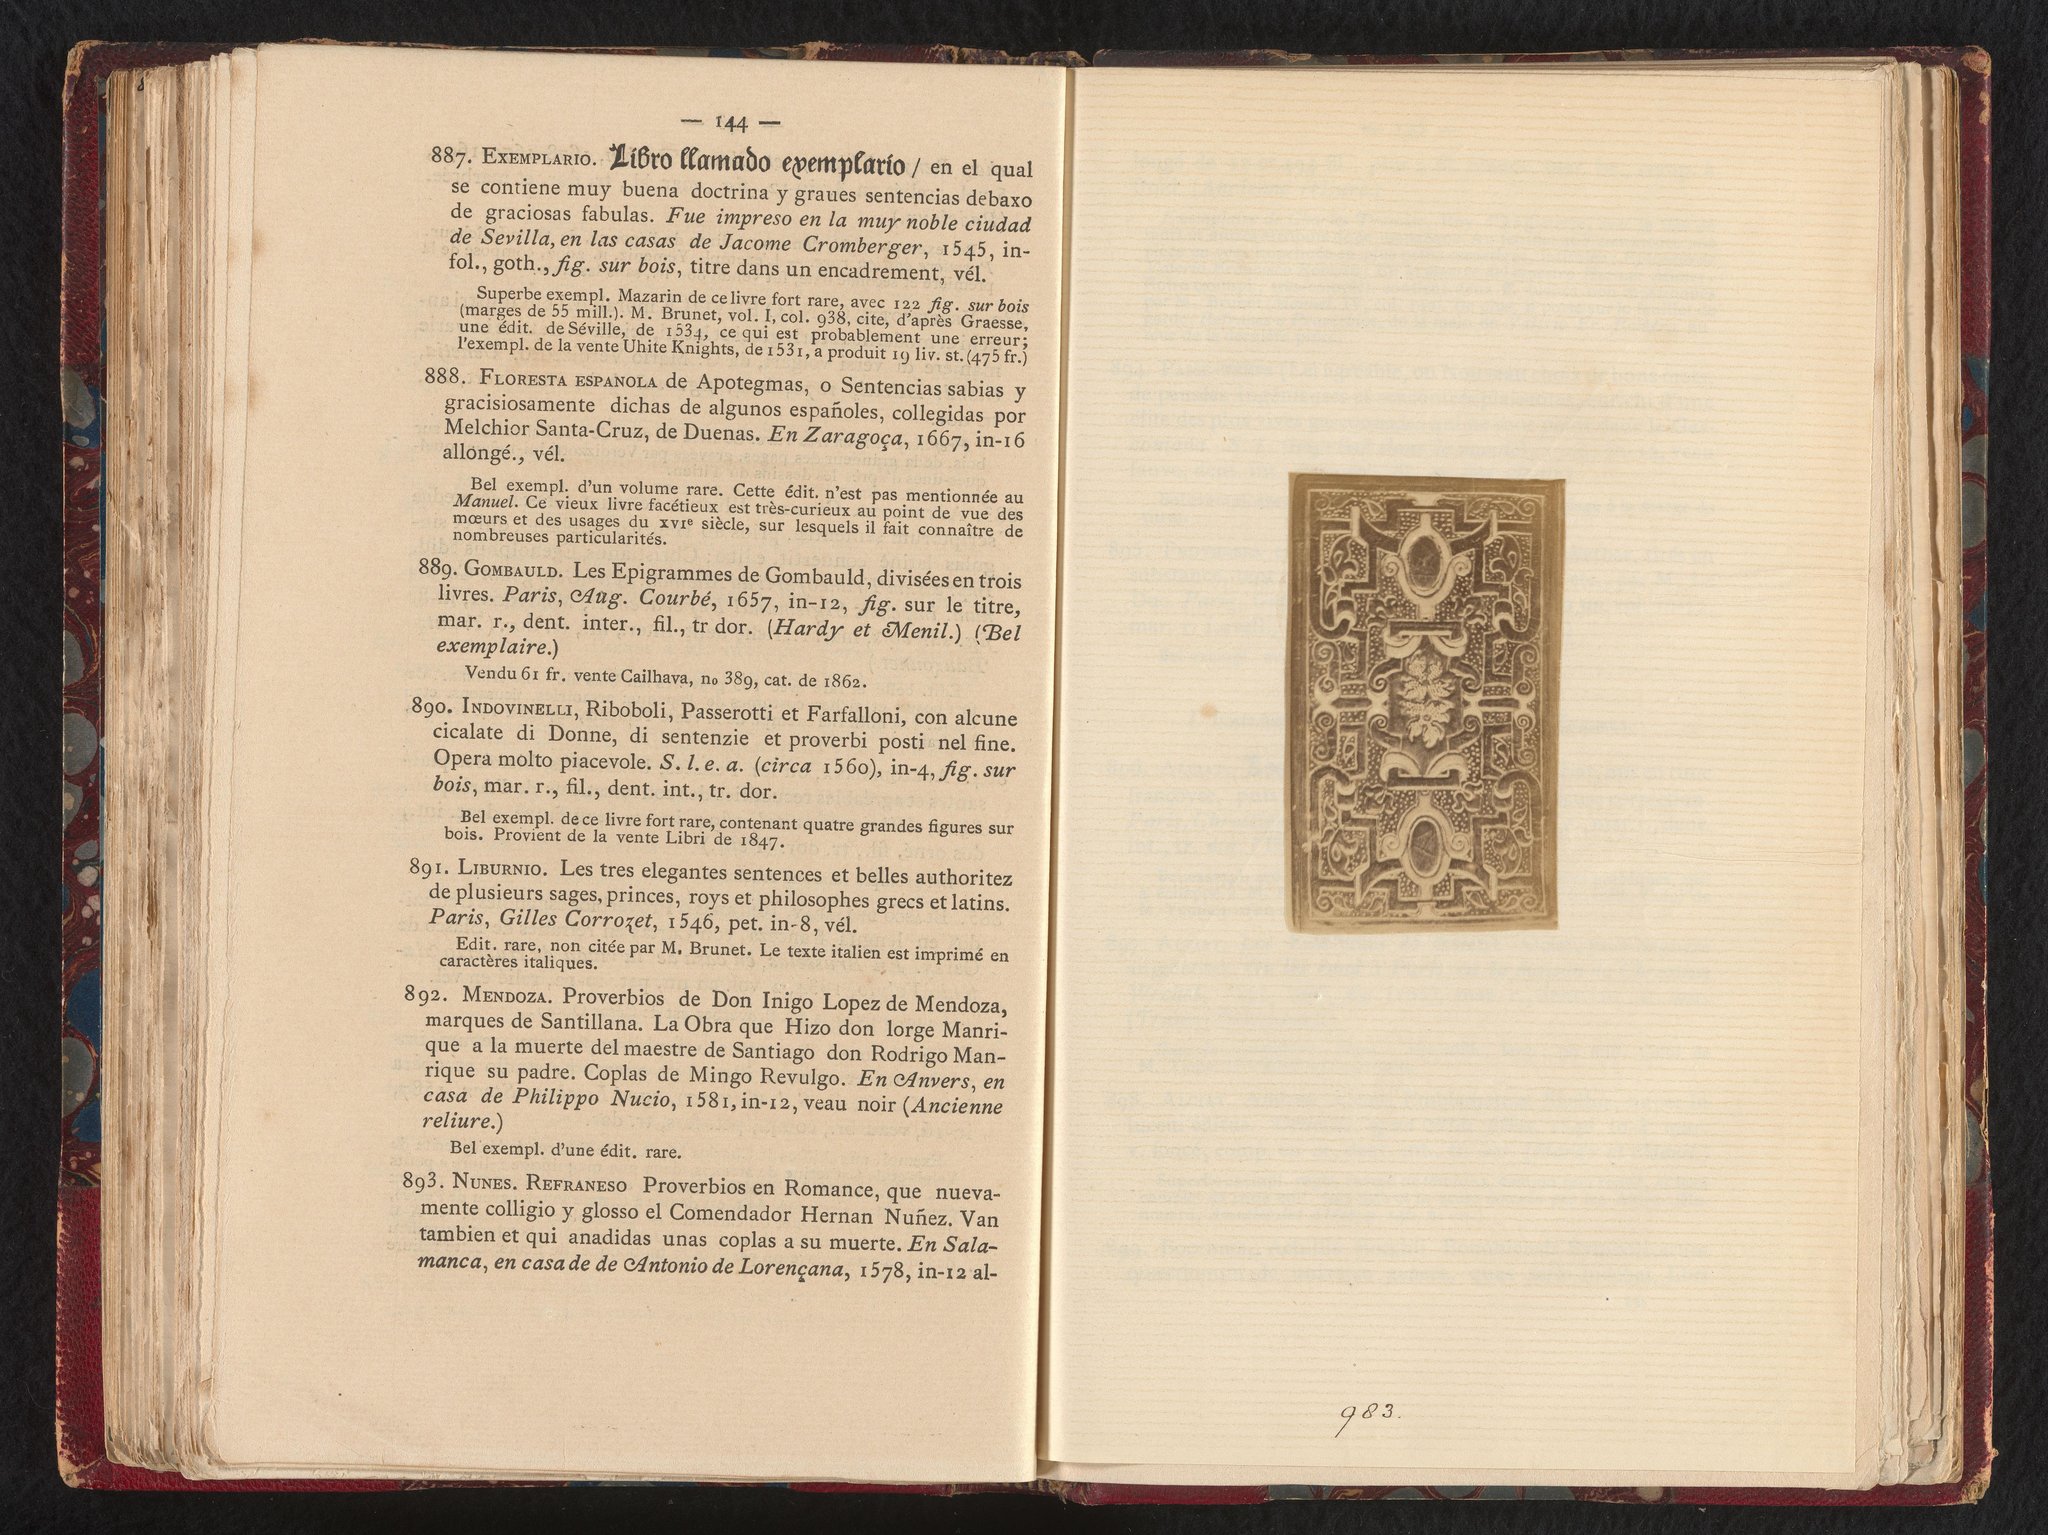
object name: page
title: Fotoreproductie van boekomslag van Caesarum Vitae post Suetonium Tranquillum conscriptae uit 1551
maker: Anonymous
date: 1863-1868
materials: paper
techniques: albumen print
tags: book-cover, binding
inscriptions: number: ‘983’